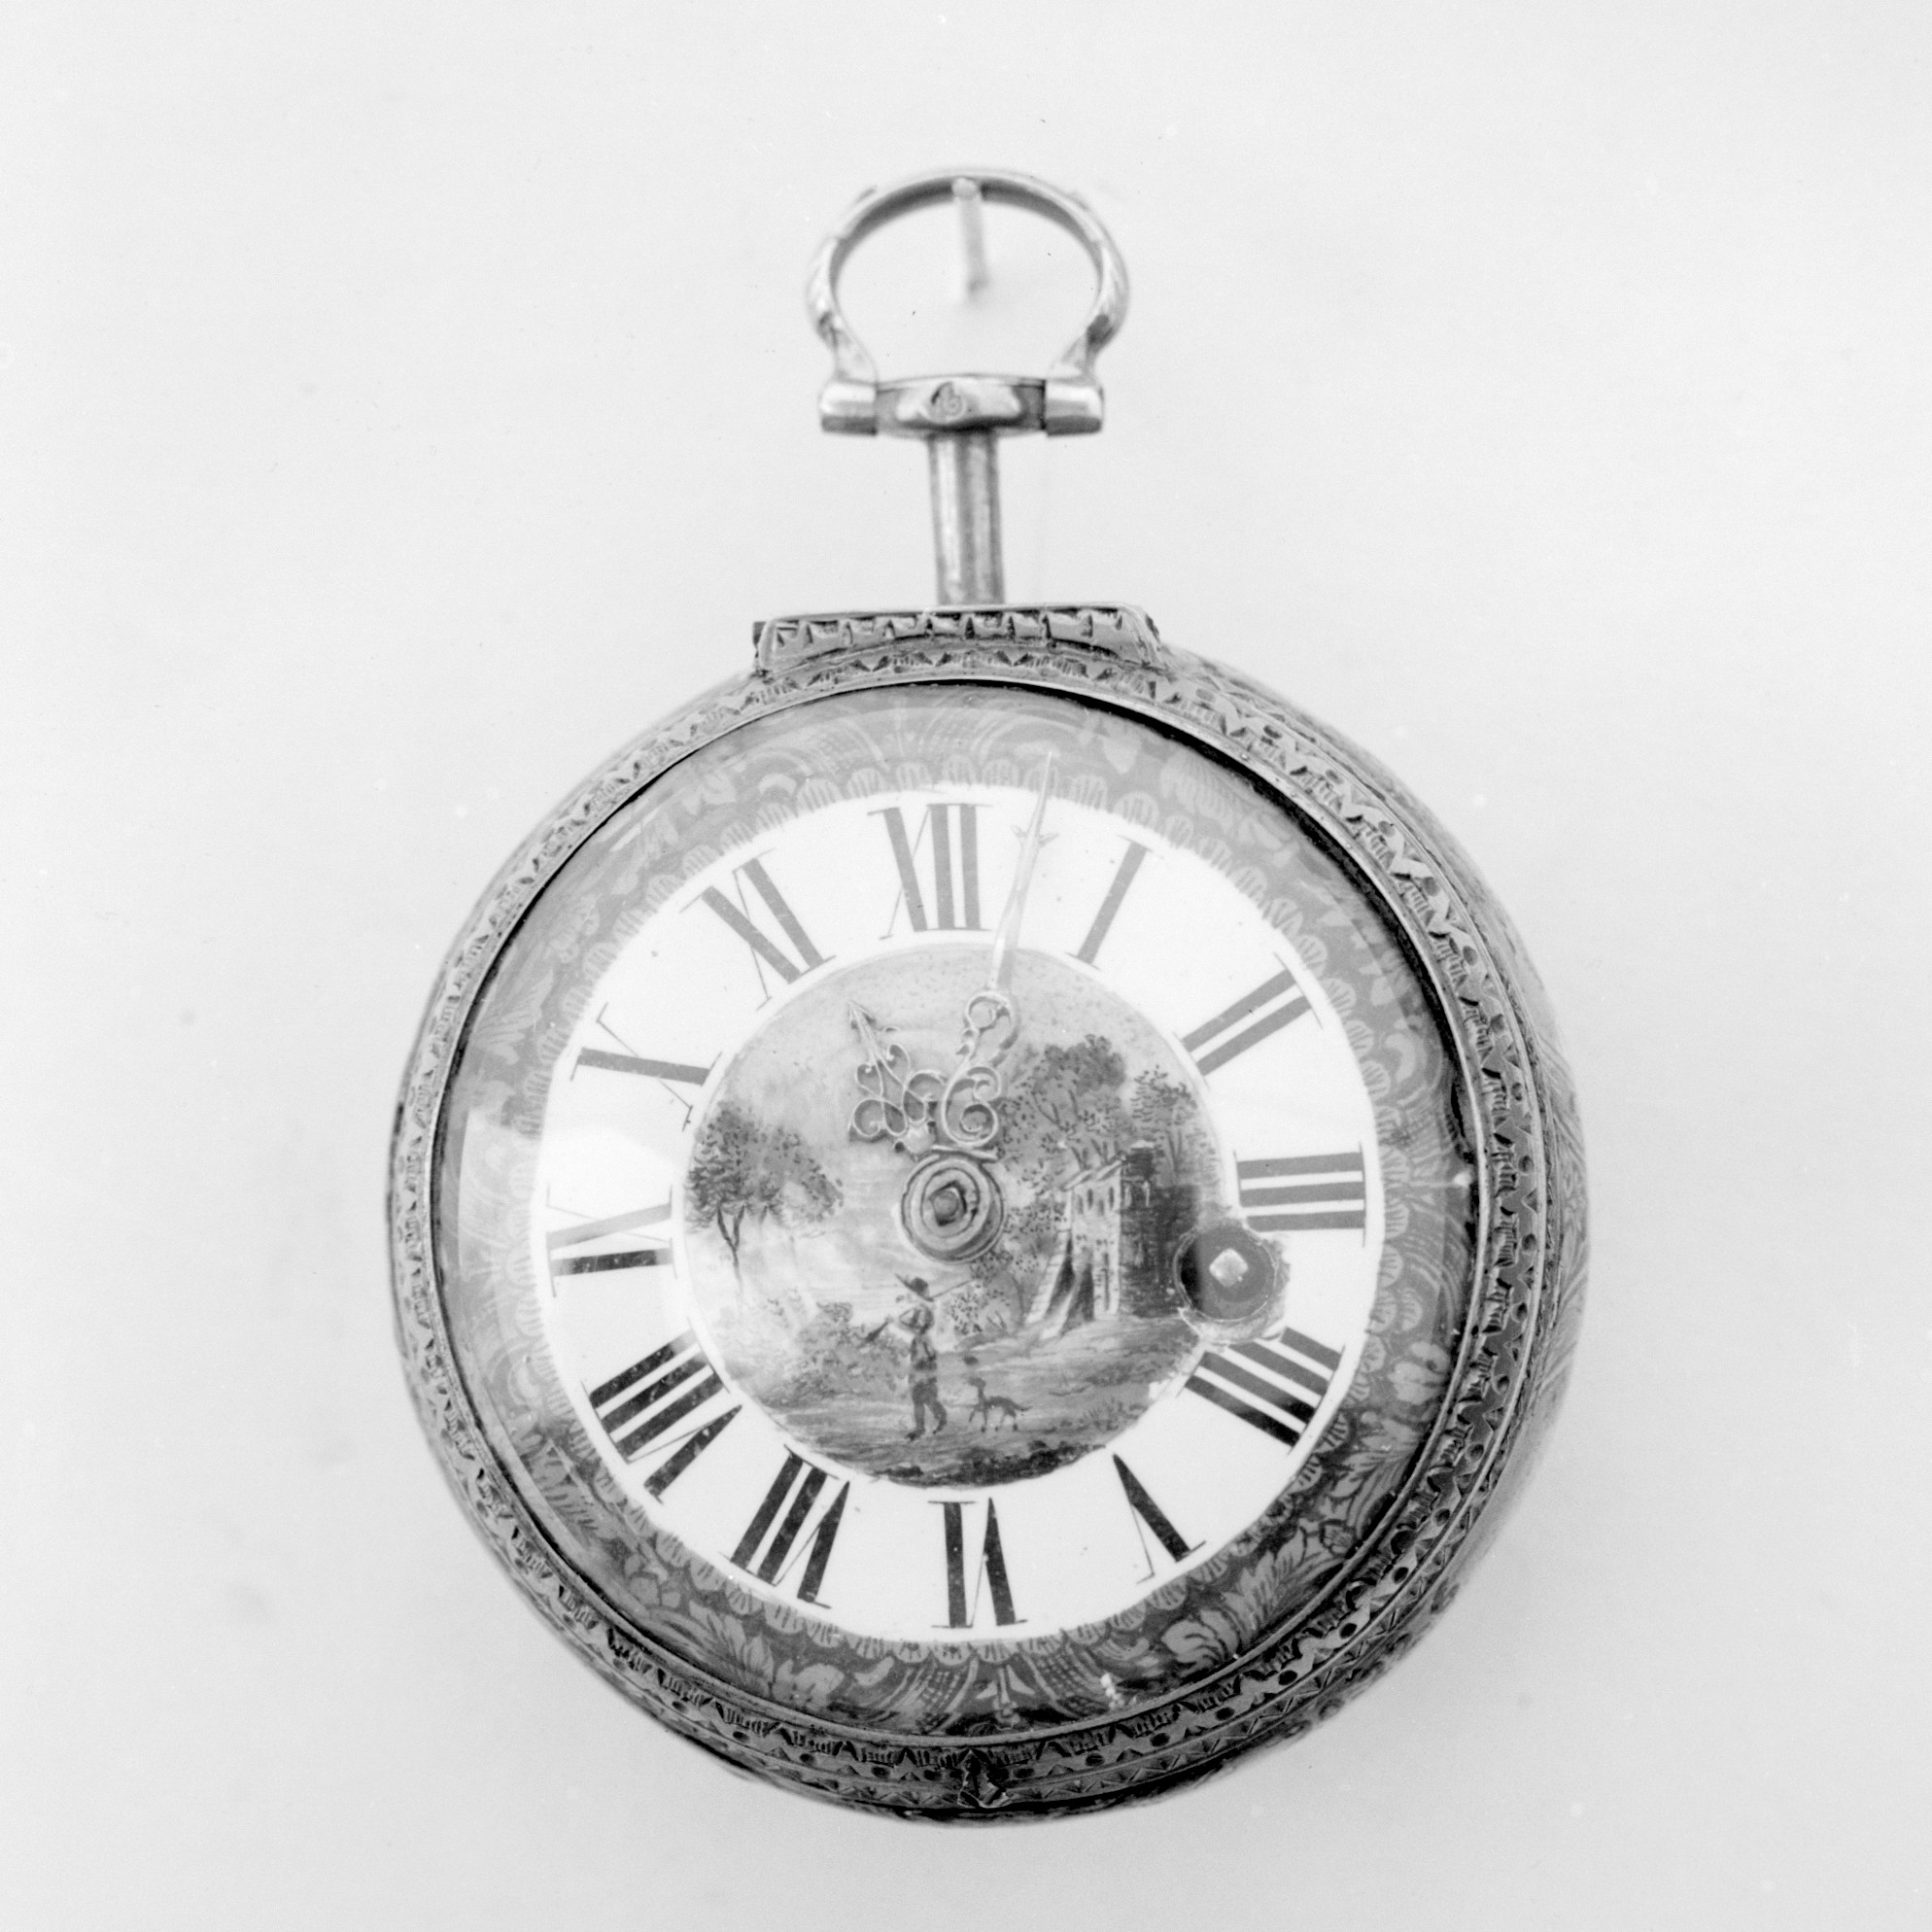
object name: watch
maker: jean-pierre huaud, known as the younger huaud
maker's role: enameler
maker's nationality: swiss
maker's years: 1655-1723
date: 1767-1800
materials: enamel, gold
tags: animals,men,trees